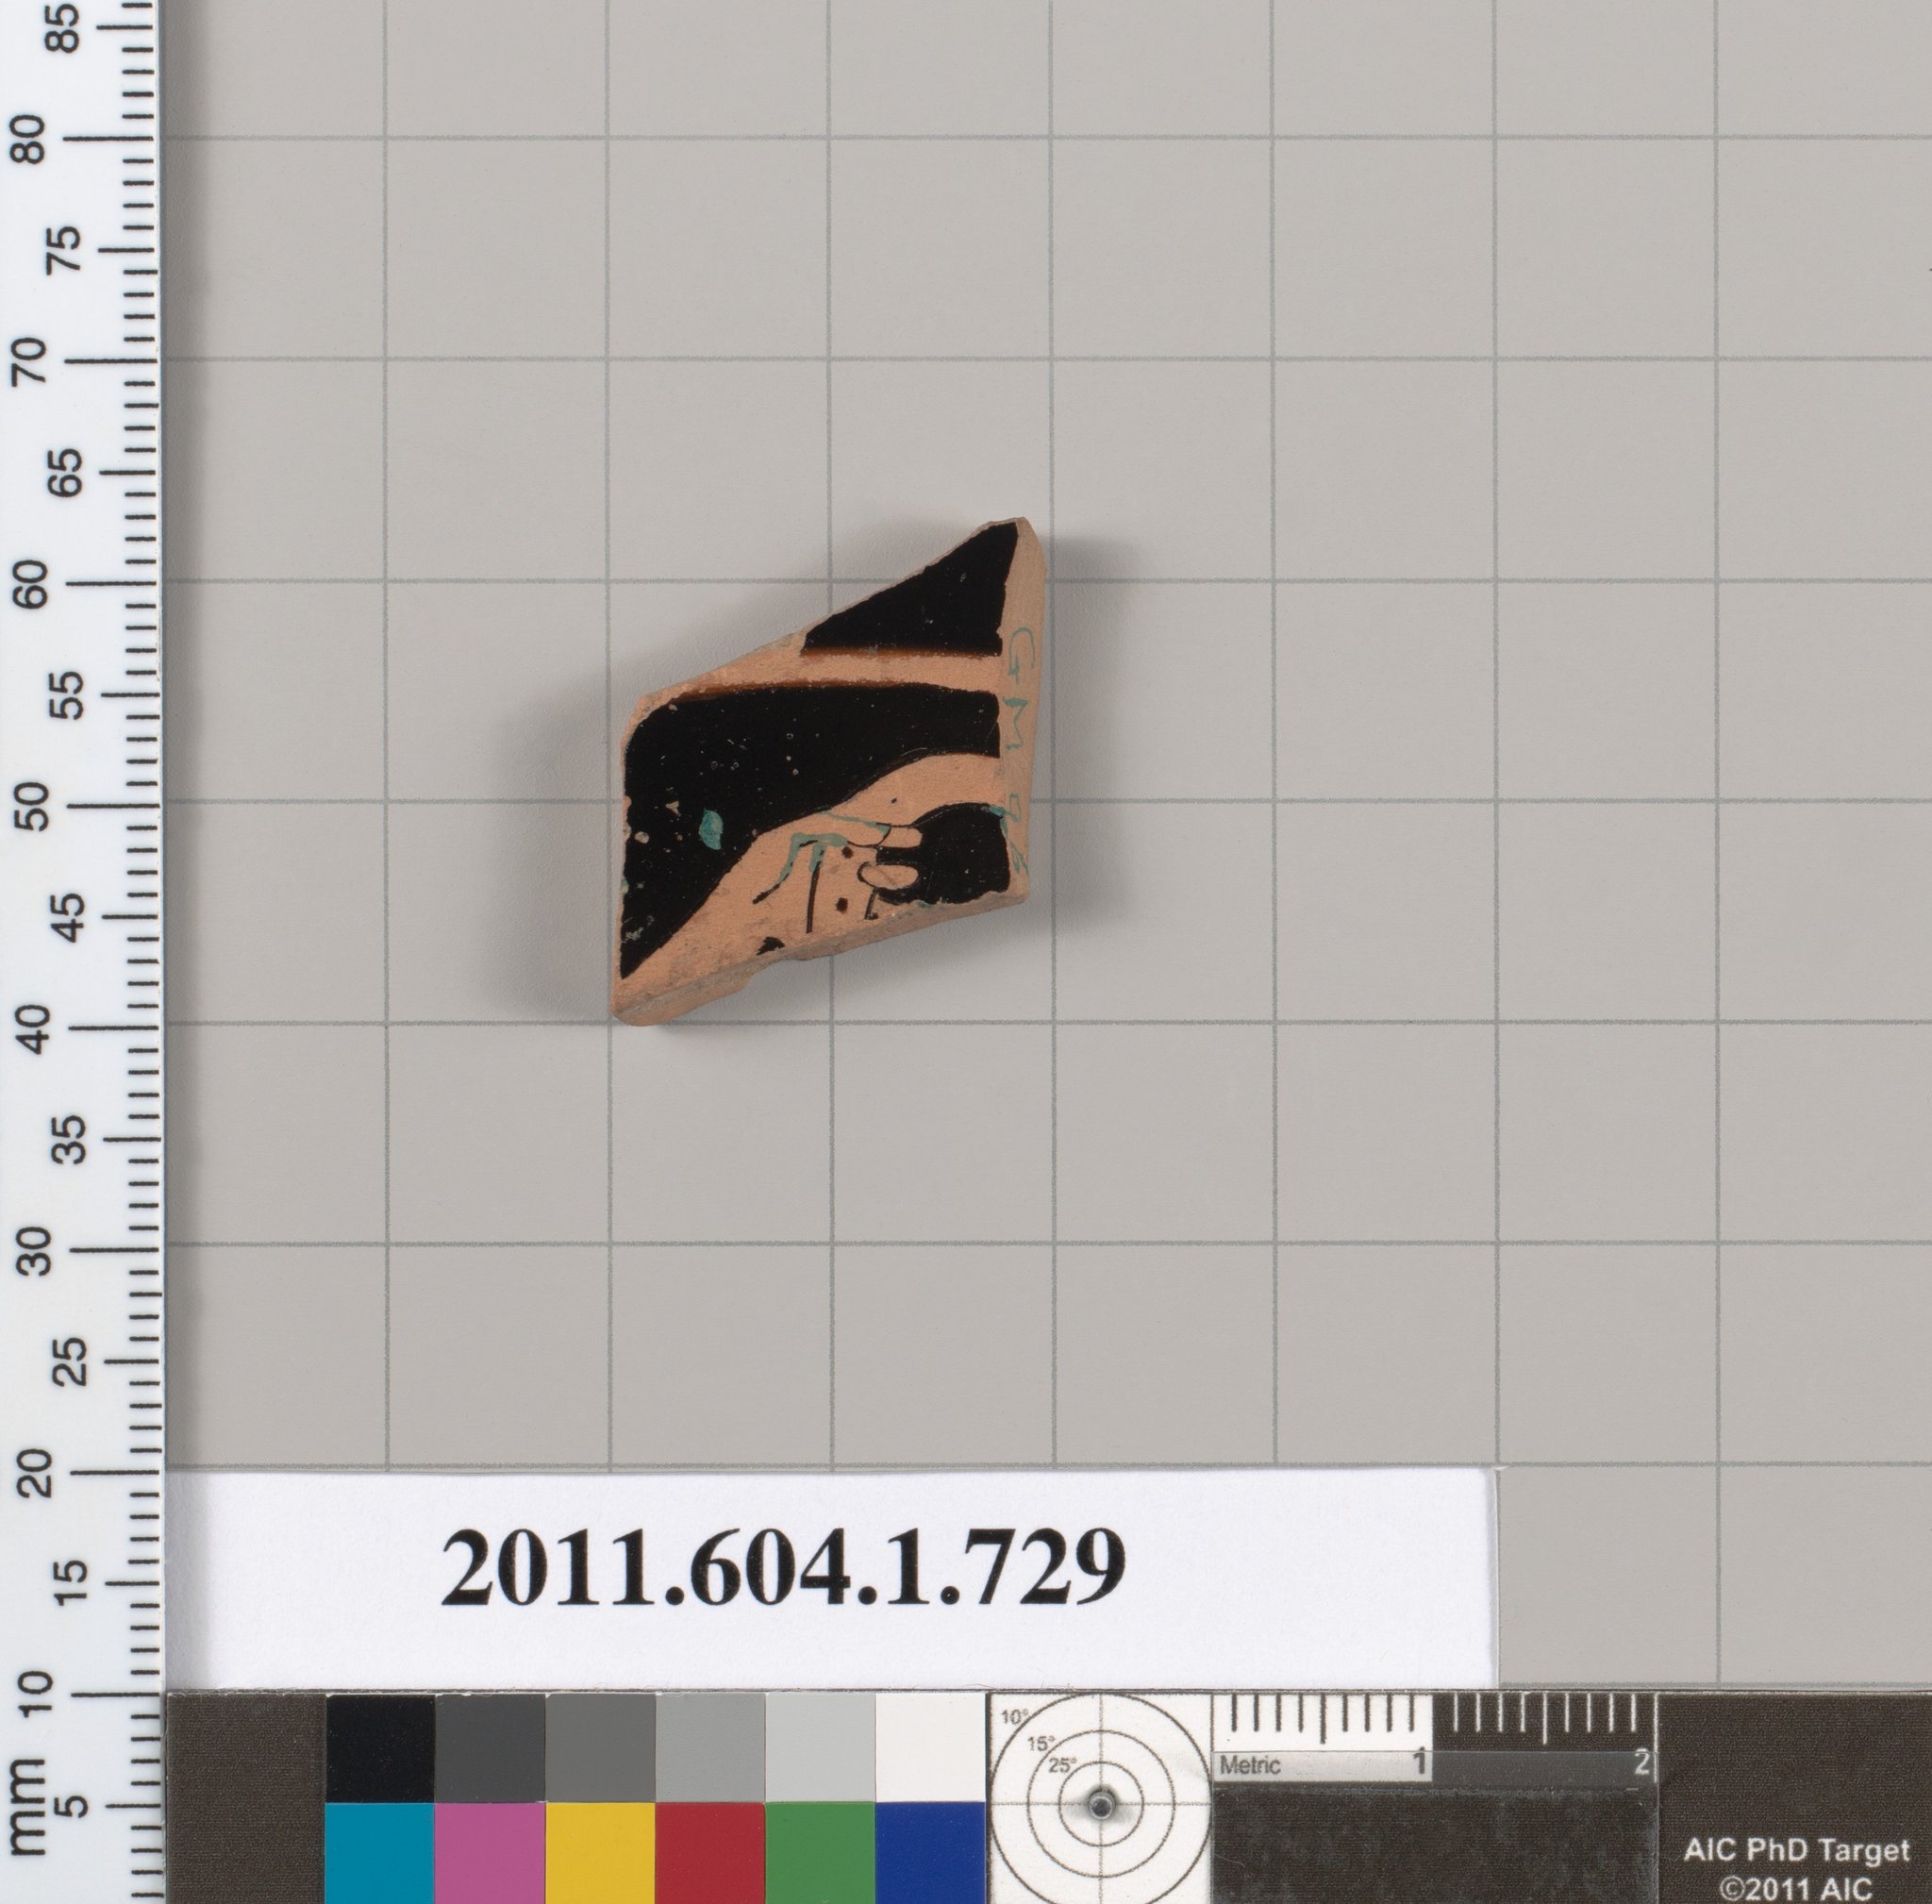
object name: kylix fragment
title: Terracotta fragment of a kylix (drinking cup)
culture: greek, attic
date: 475-451 BCE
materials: terracotta